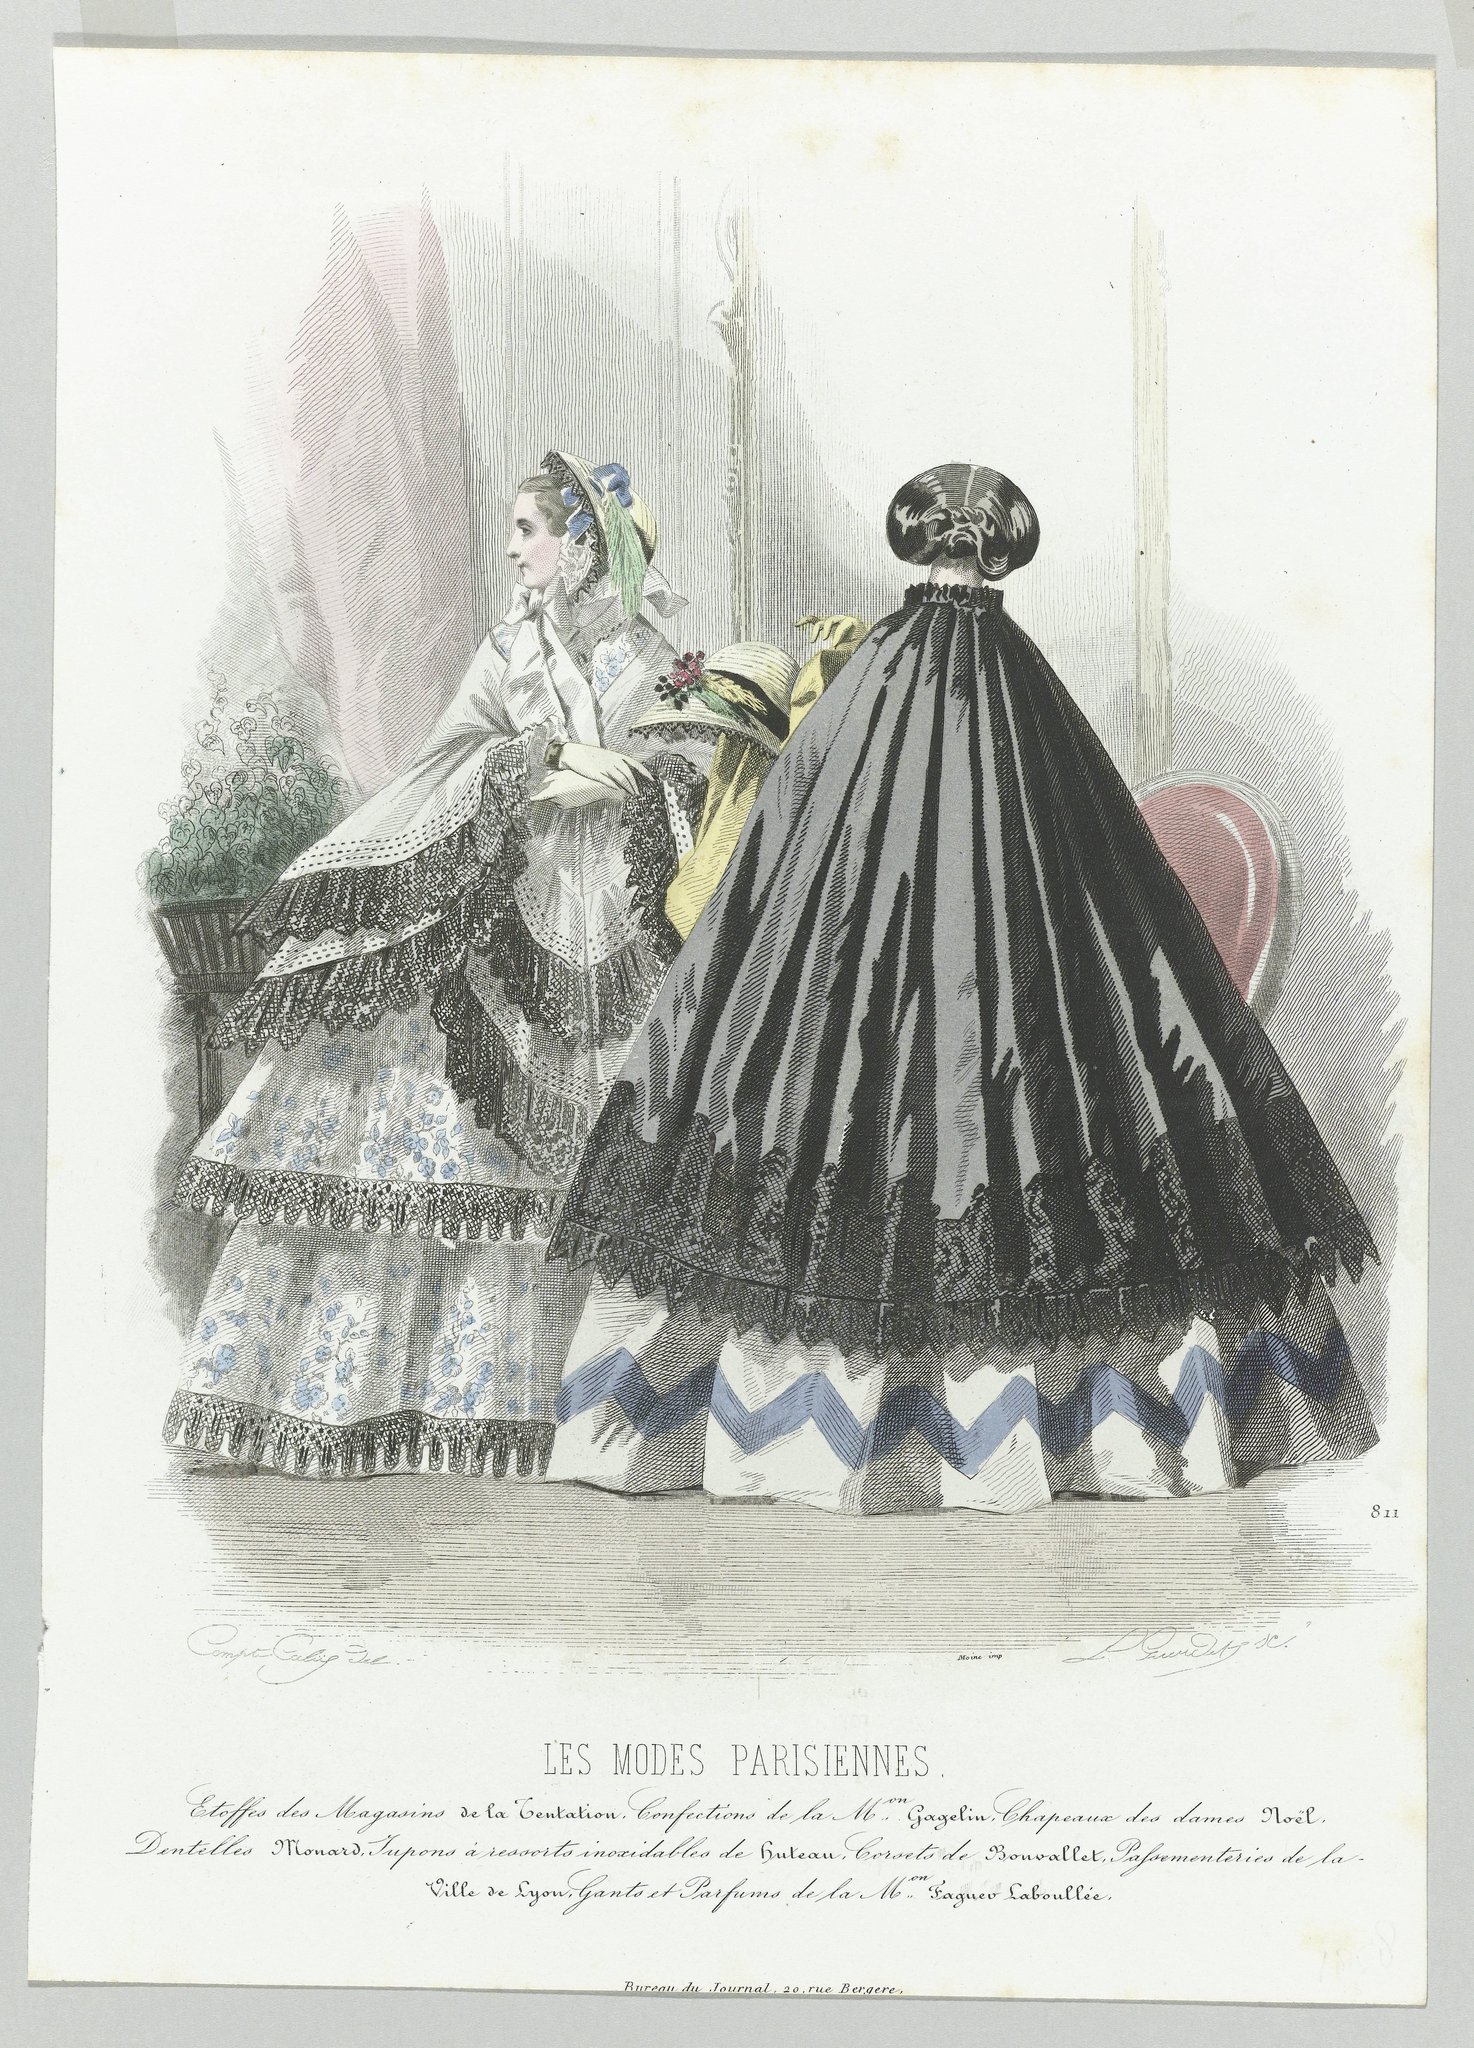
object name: fashion print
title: An Explosion of Fashion Magazines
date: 1858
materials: paper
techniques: engraving, hand coloring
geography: paris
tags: ornamental parts of clothing (+ women's clothes), lace (+ women's clothes), skirt (crinoline skirt) (+ women's clothes), cape (+ women's clothes), fashion plates, head-gear: hat (+ women's clothes), gloves, mittens, etc. (+ women's clothes), necklace (+ women's clothes)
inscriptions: caption: ‘Etoffes des Magasins de la Tentation, Confections de la M"on Gagelin, Chapeaux des dames Noël. Dentelles Monard, Jupons à ressorts inoxidables de Huteau, Corsets de Bonvallet, Passementeries de la Ville de Lyon, Gants et Parfums de la M"on Faguer Laboullée.’, address: ‘Bureau du Journal, 20, rue Bergère.’, title: ‘Les Modes Parisiennes’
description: Starting from the 1850s, fashion magazines became more affordable and acquired a wider readership. The invention of the sewing machine around 1850 made it easier for people to make their own clothes. Ready-made garments were now also on offer, with fashion plates providing vendor addresses, such as the Maison Gagelin in Paris.